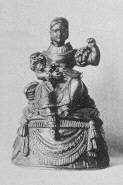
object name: hand bell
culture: french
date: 1801-1900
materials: metal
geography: france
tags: girls